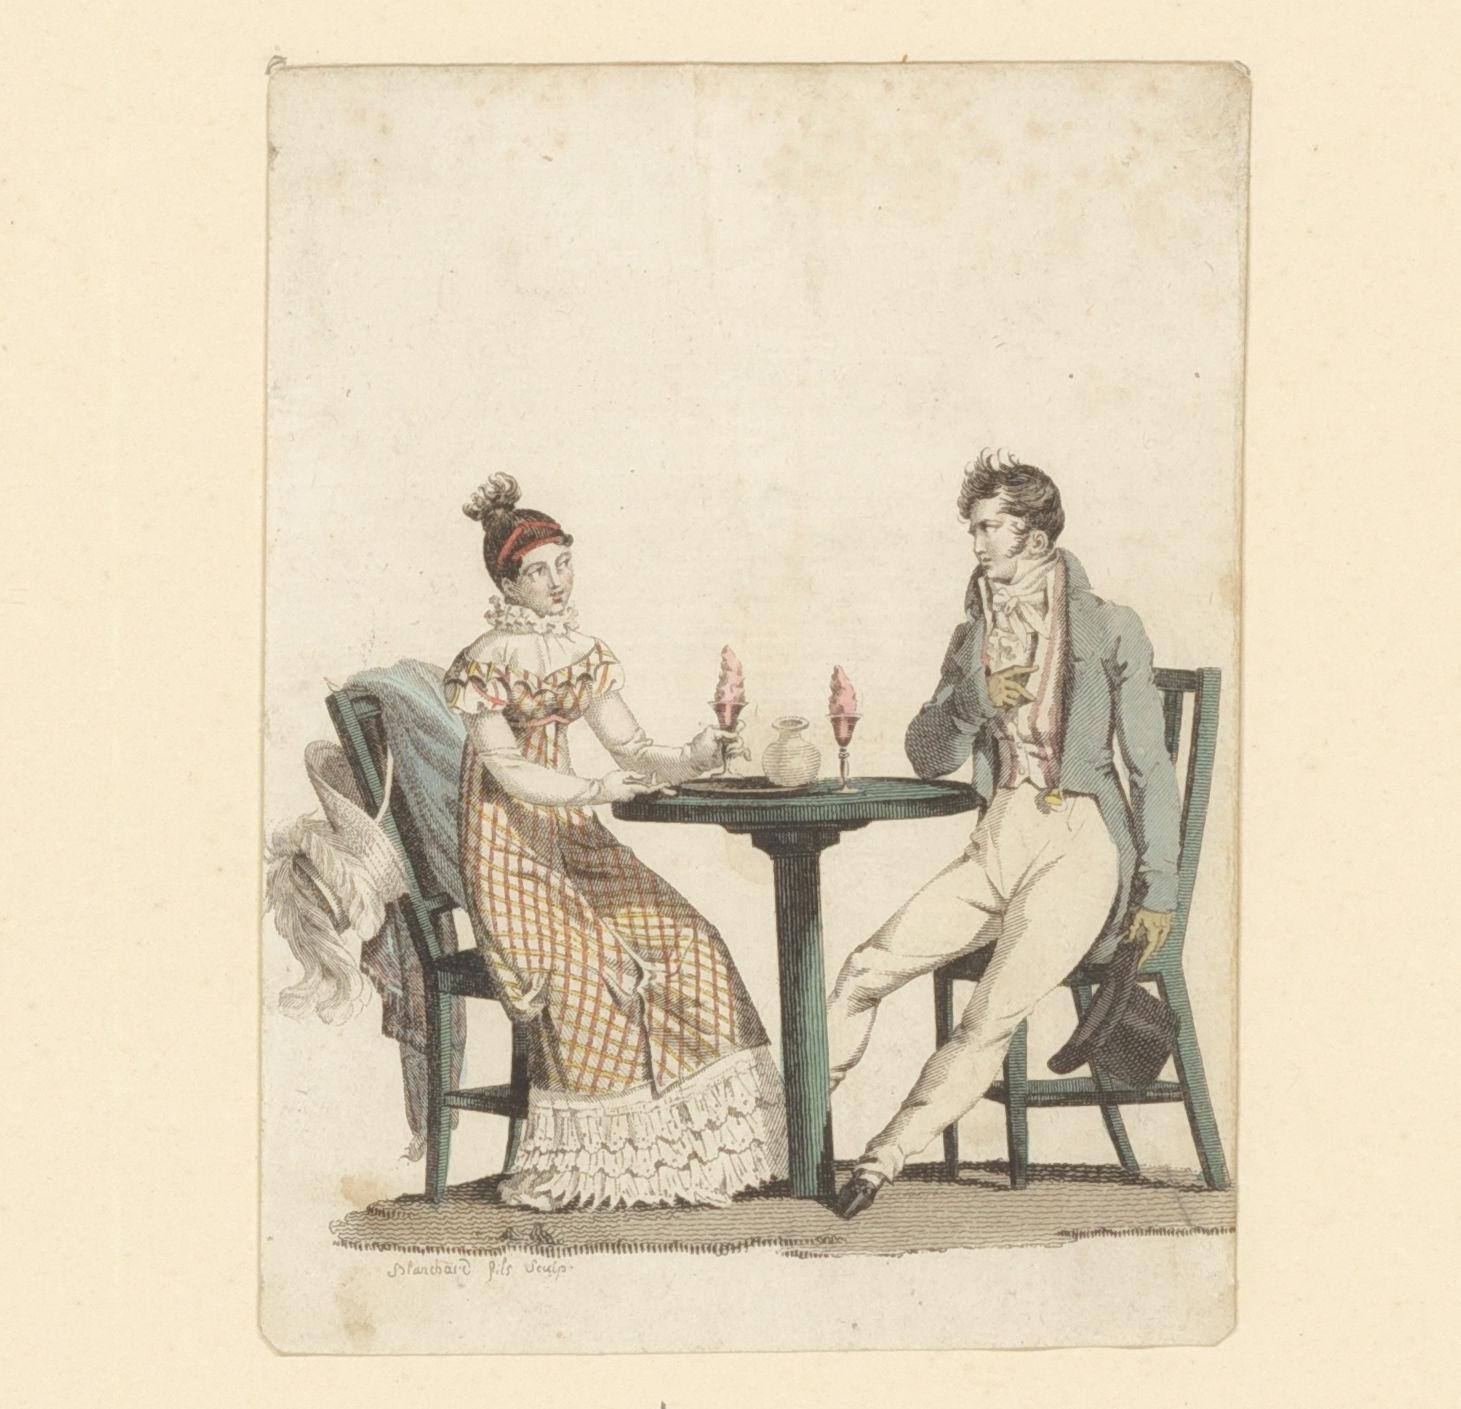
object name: print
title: Vier seizoenen mode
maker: auguste thomas marie blanchard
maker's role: print maker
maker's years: 1819-1898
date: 1830-1898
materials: paper, watercolor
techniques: engraving, etching, hand coloring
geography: france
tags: head-gear (+ women's clothes), summer ~ human activities (the four seasons of the year), fashion plates, dress, gown (+ women's clothes)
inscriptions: collector's mark, collector's mark: Lugt 1641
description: Een man en een vrouw zittend aan een tafel met ijscoupes. Onderdeel van een serie van vier prenten van de mode van ca. 1813 per seizoen. Onderwerpsrubrieken binnen de Atlas Zeden en Gewoonten: De Kleeding, Modeplaten.